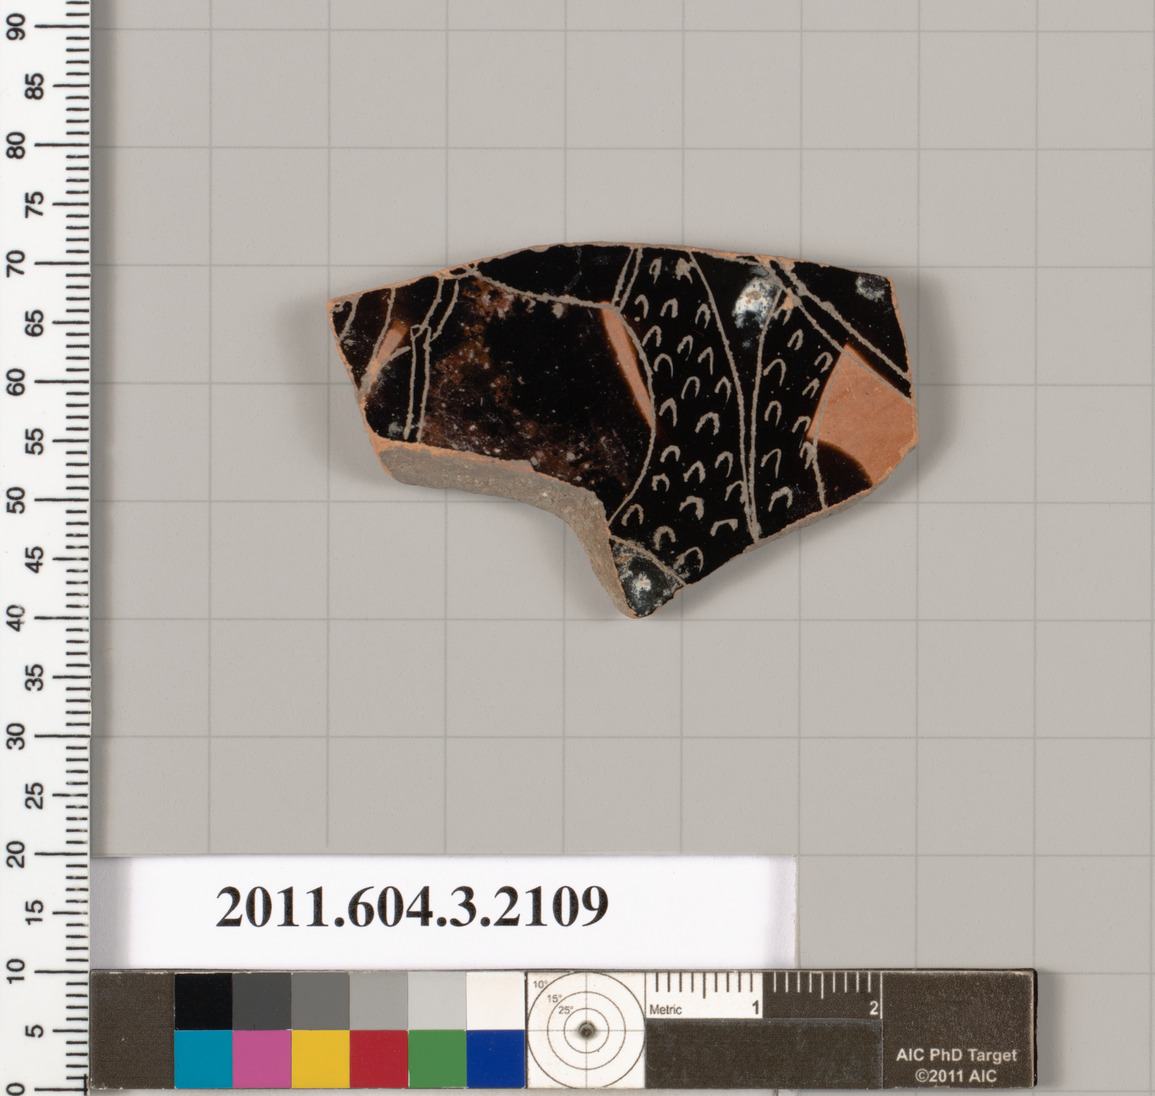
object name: kylix fragment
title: Terracotta fragment of a kylix (drinking cup)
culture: greek, attic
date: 530-510 BCE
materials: terracotta